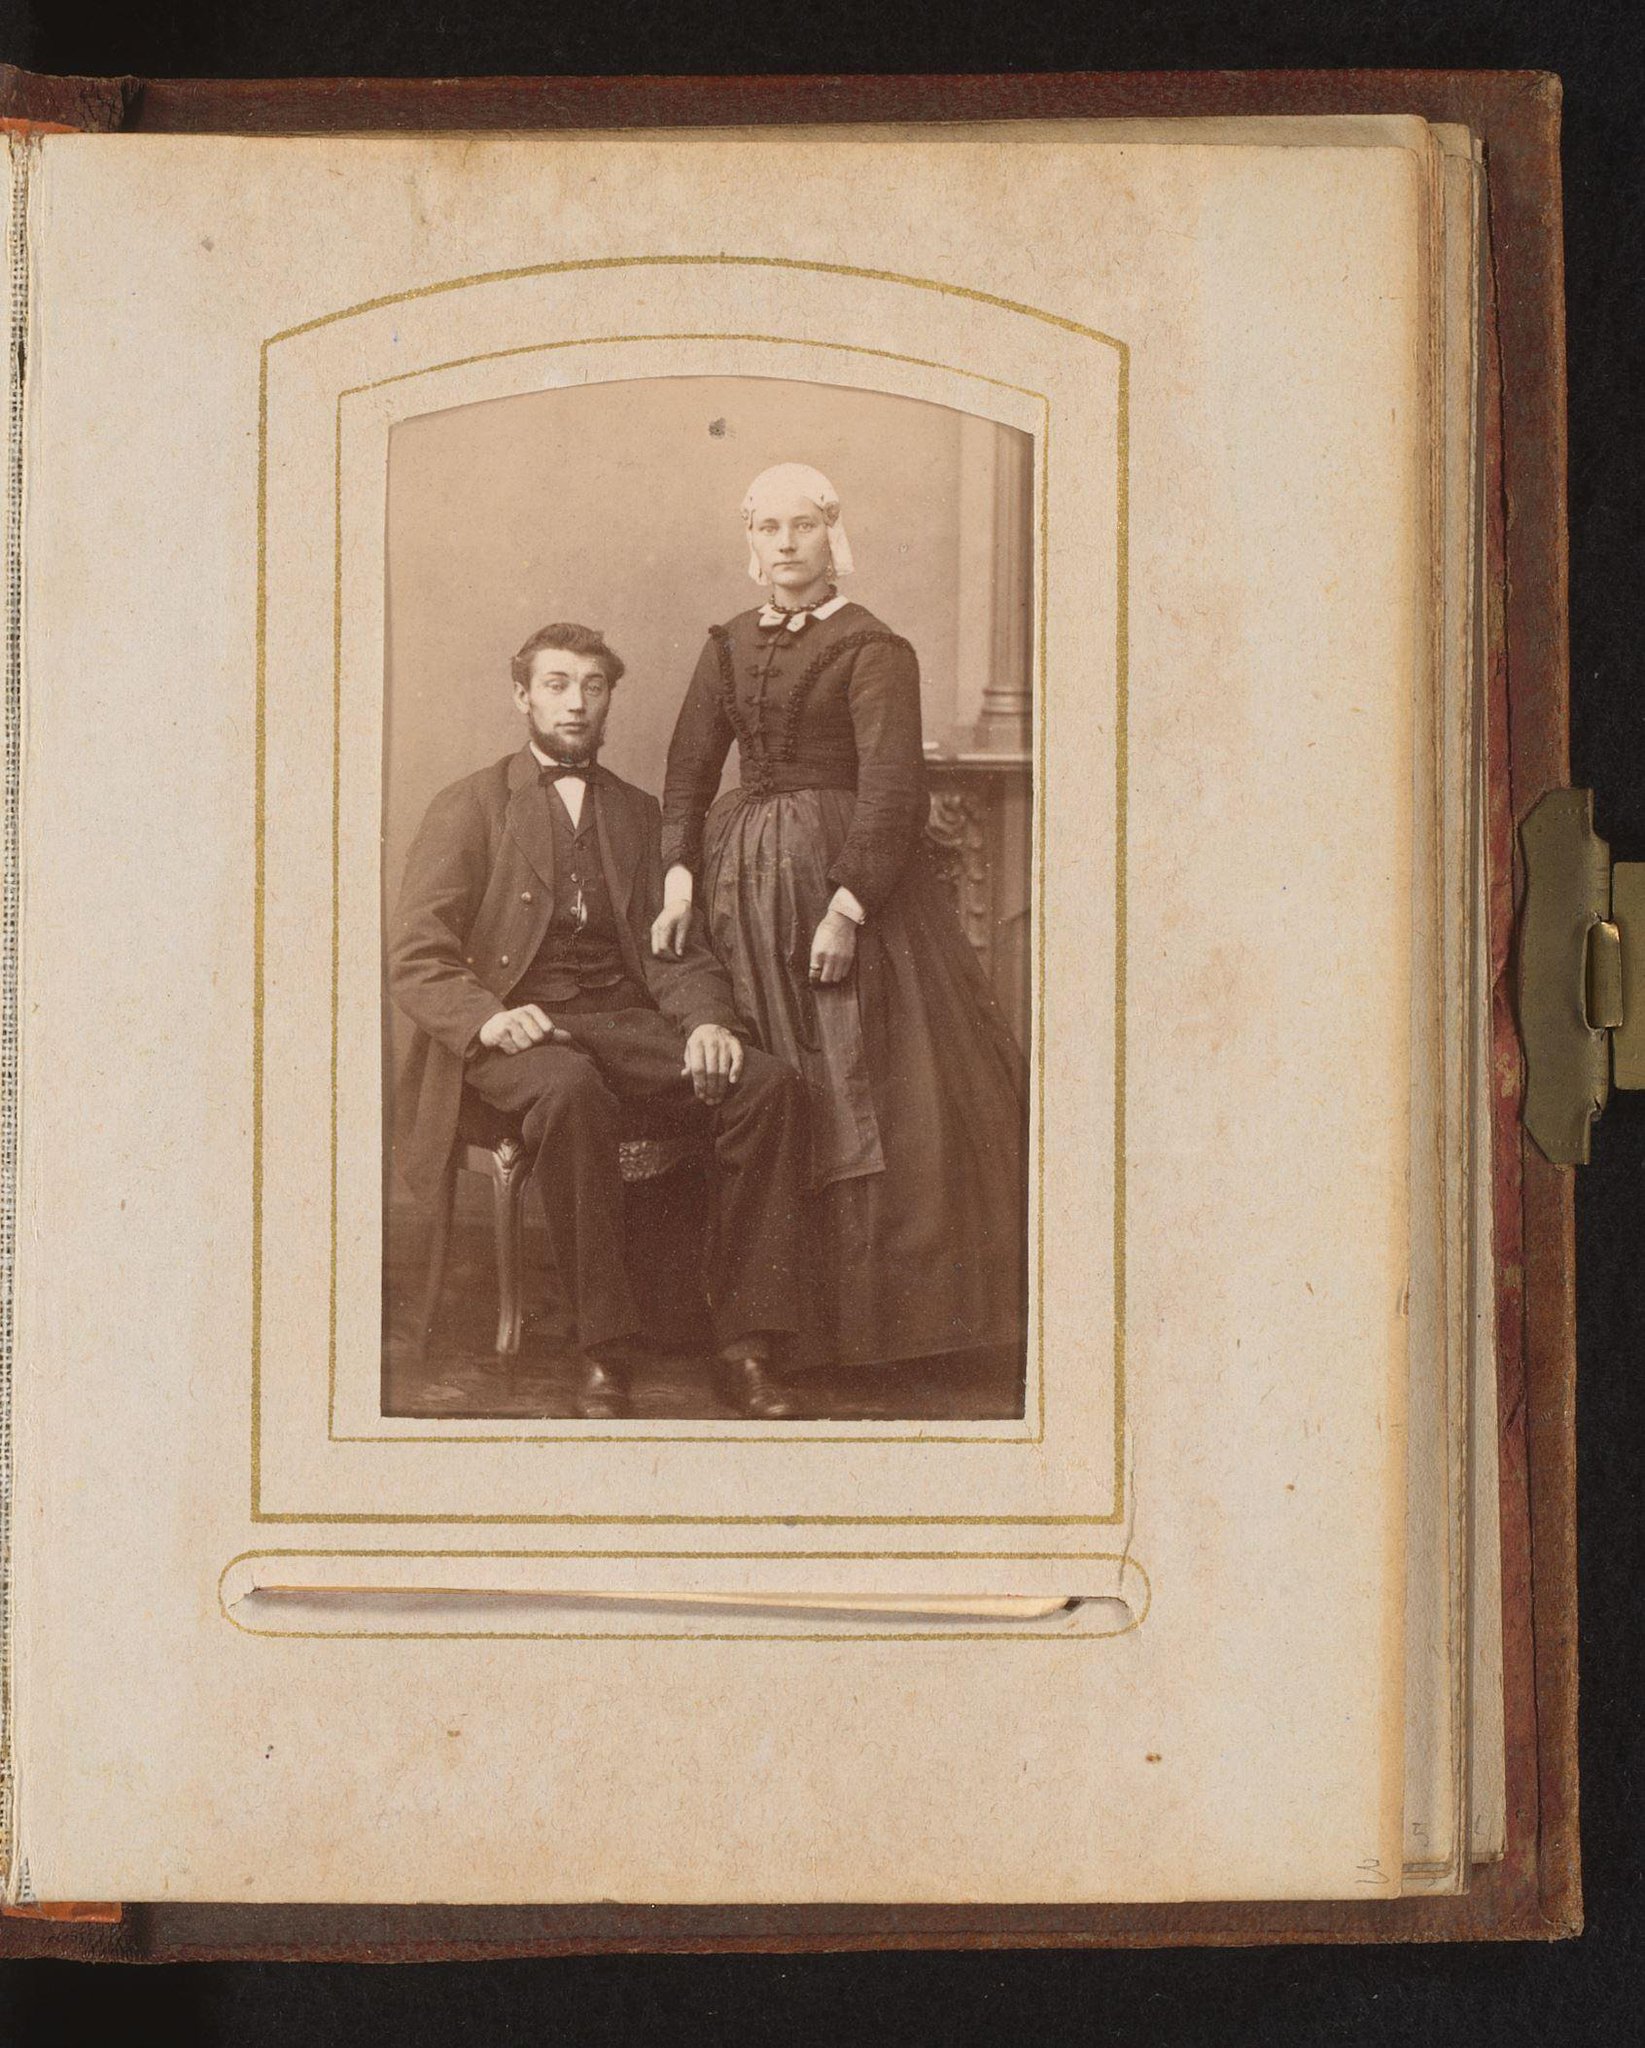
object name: album leaf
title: Portret van een man en vrouw in klederdracht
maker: johannes gerardus kramer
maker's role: fotograaf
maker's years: 1845-1903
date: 1868-1903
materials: cardboard, photographic support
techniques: albumen print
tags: adult woman, adult man, historical persons, folk costume, regional costume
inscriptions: inscription: ‘Phototgraphisch atelier/ van/ J.G/ Kramer/ Groningen/ A. Kerk H 129/ (...)’